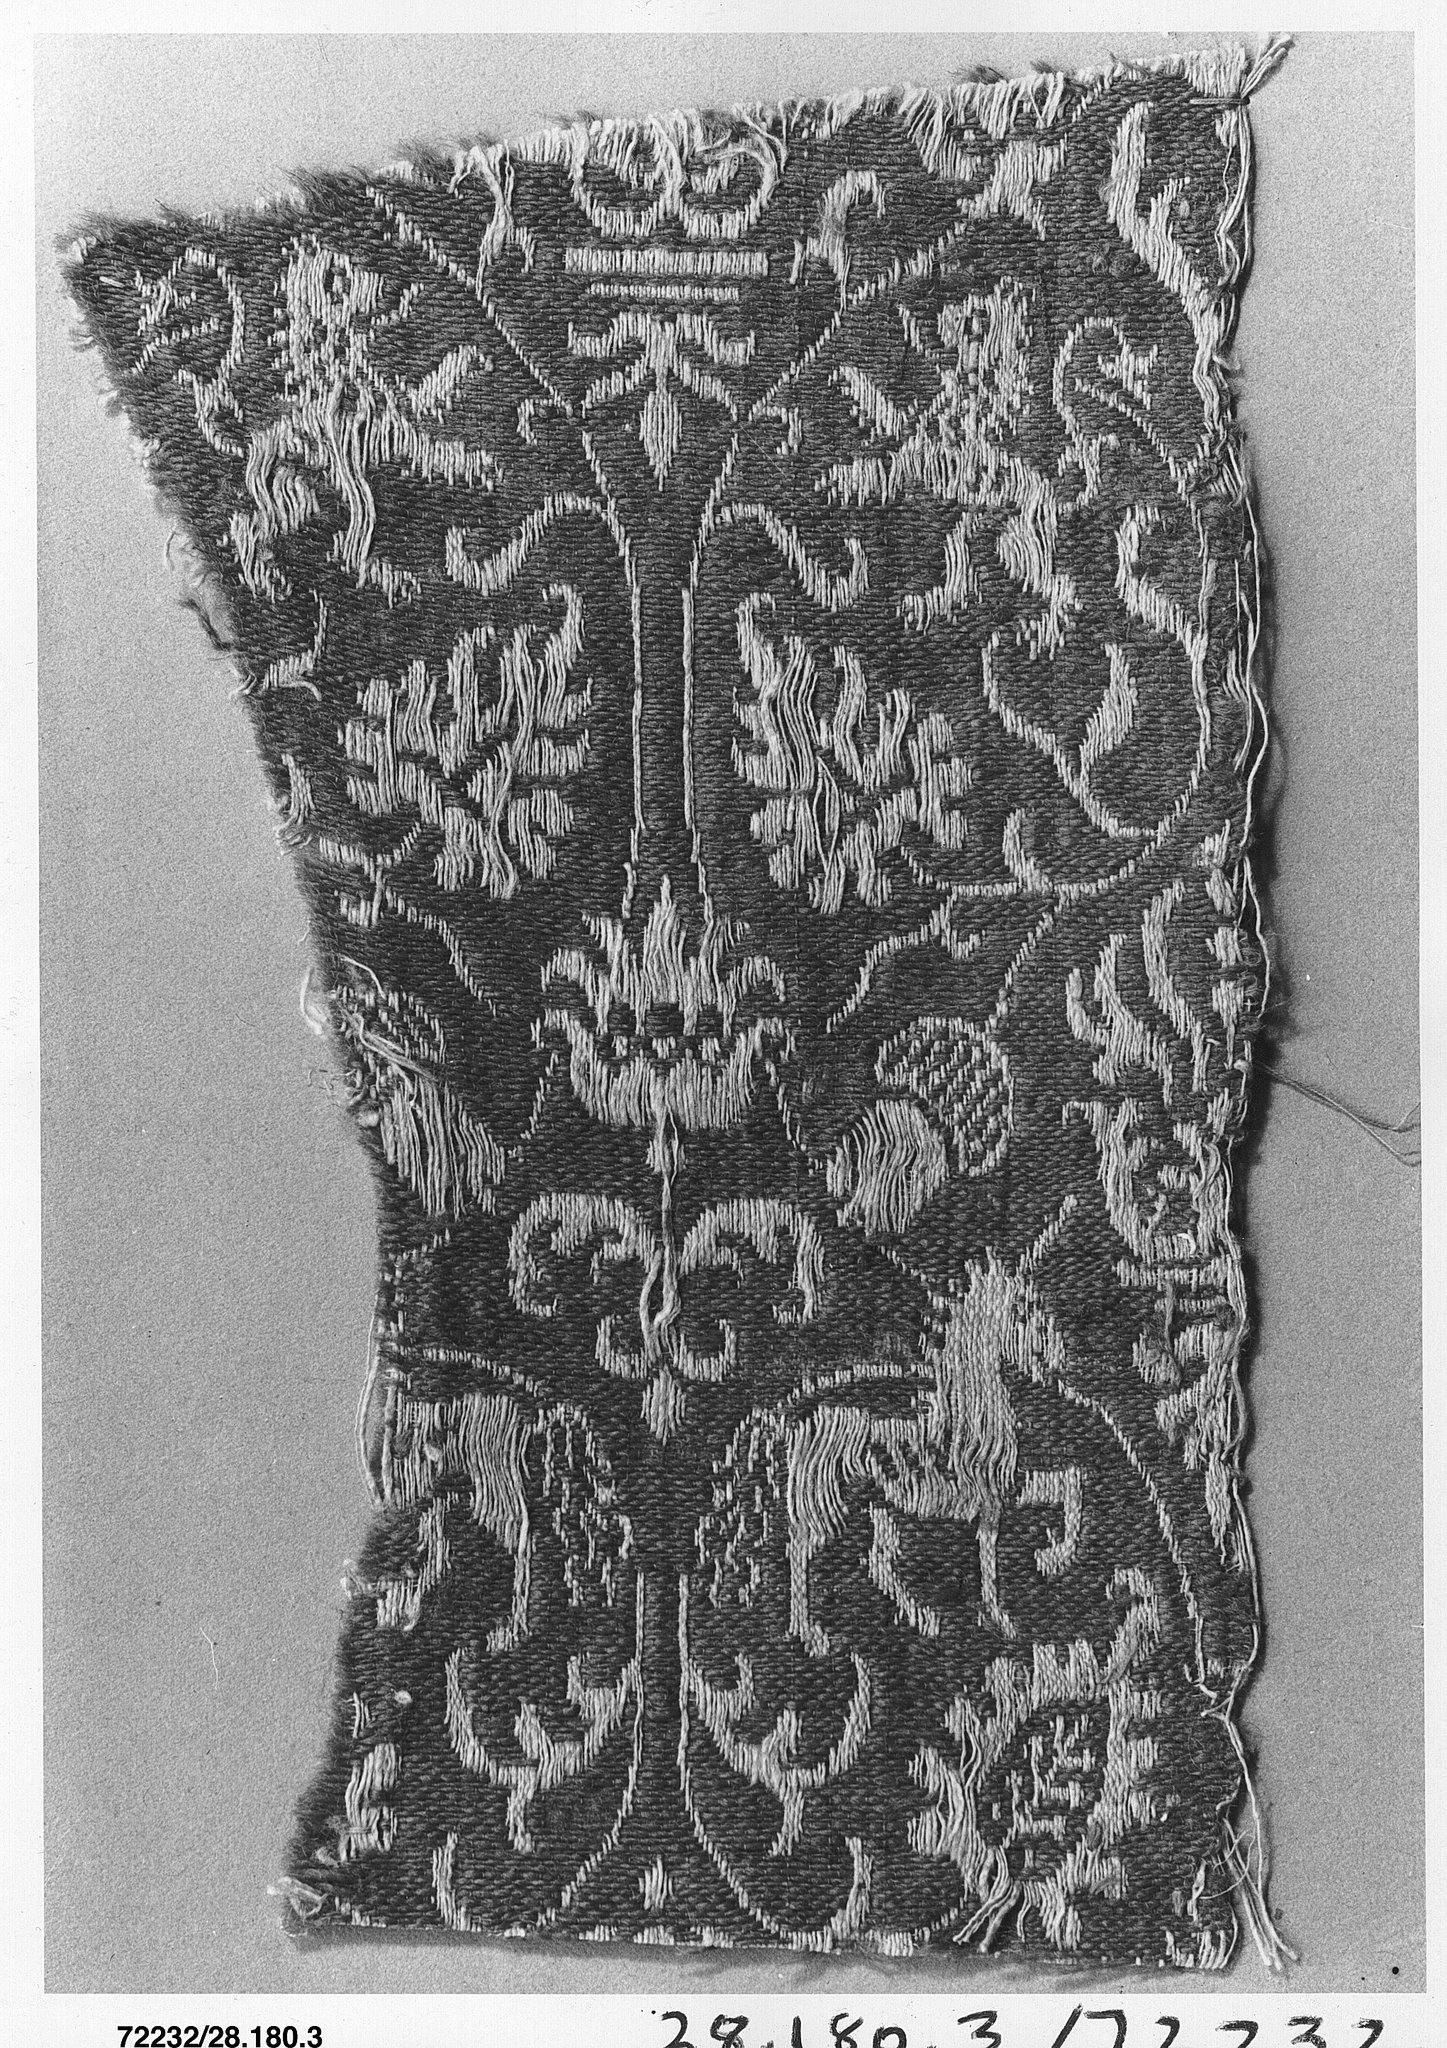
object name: fragment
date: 1534-1566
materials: linen, wool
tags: animals,flowers